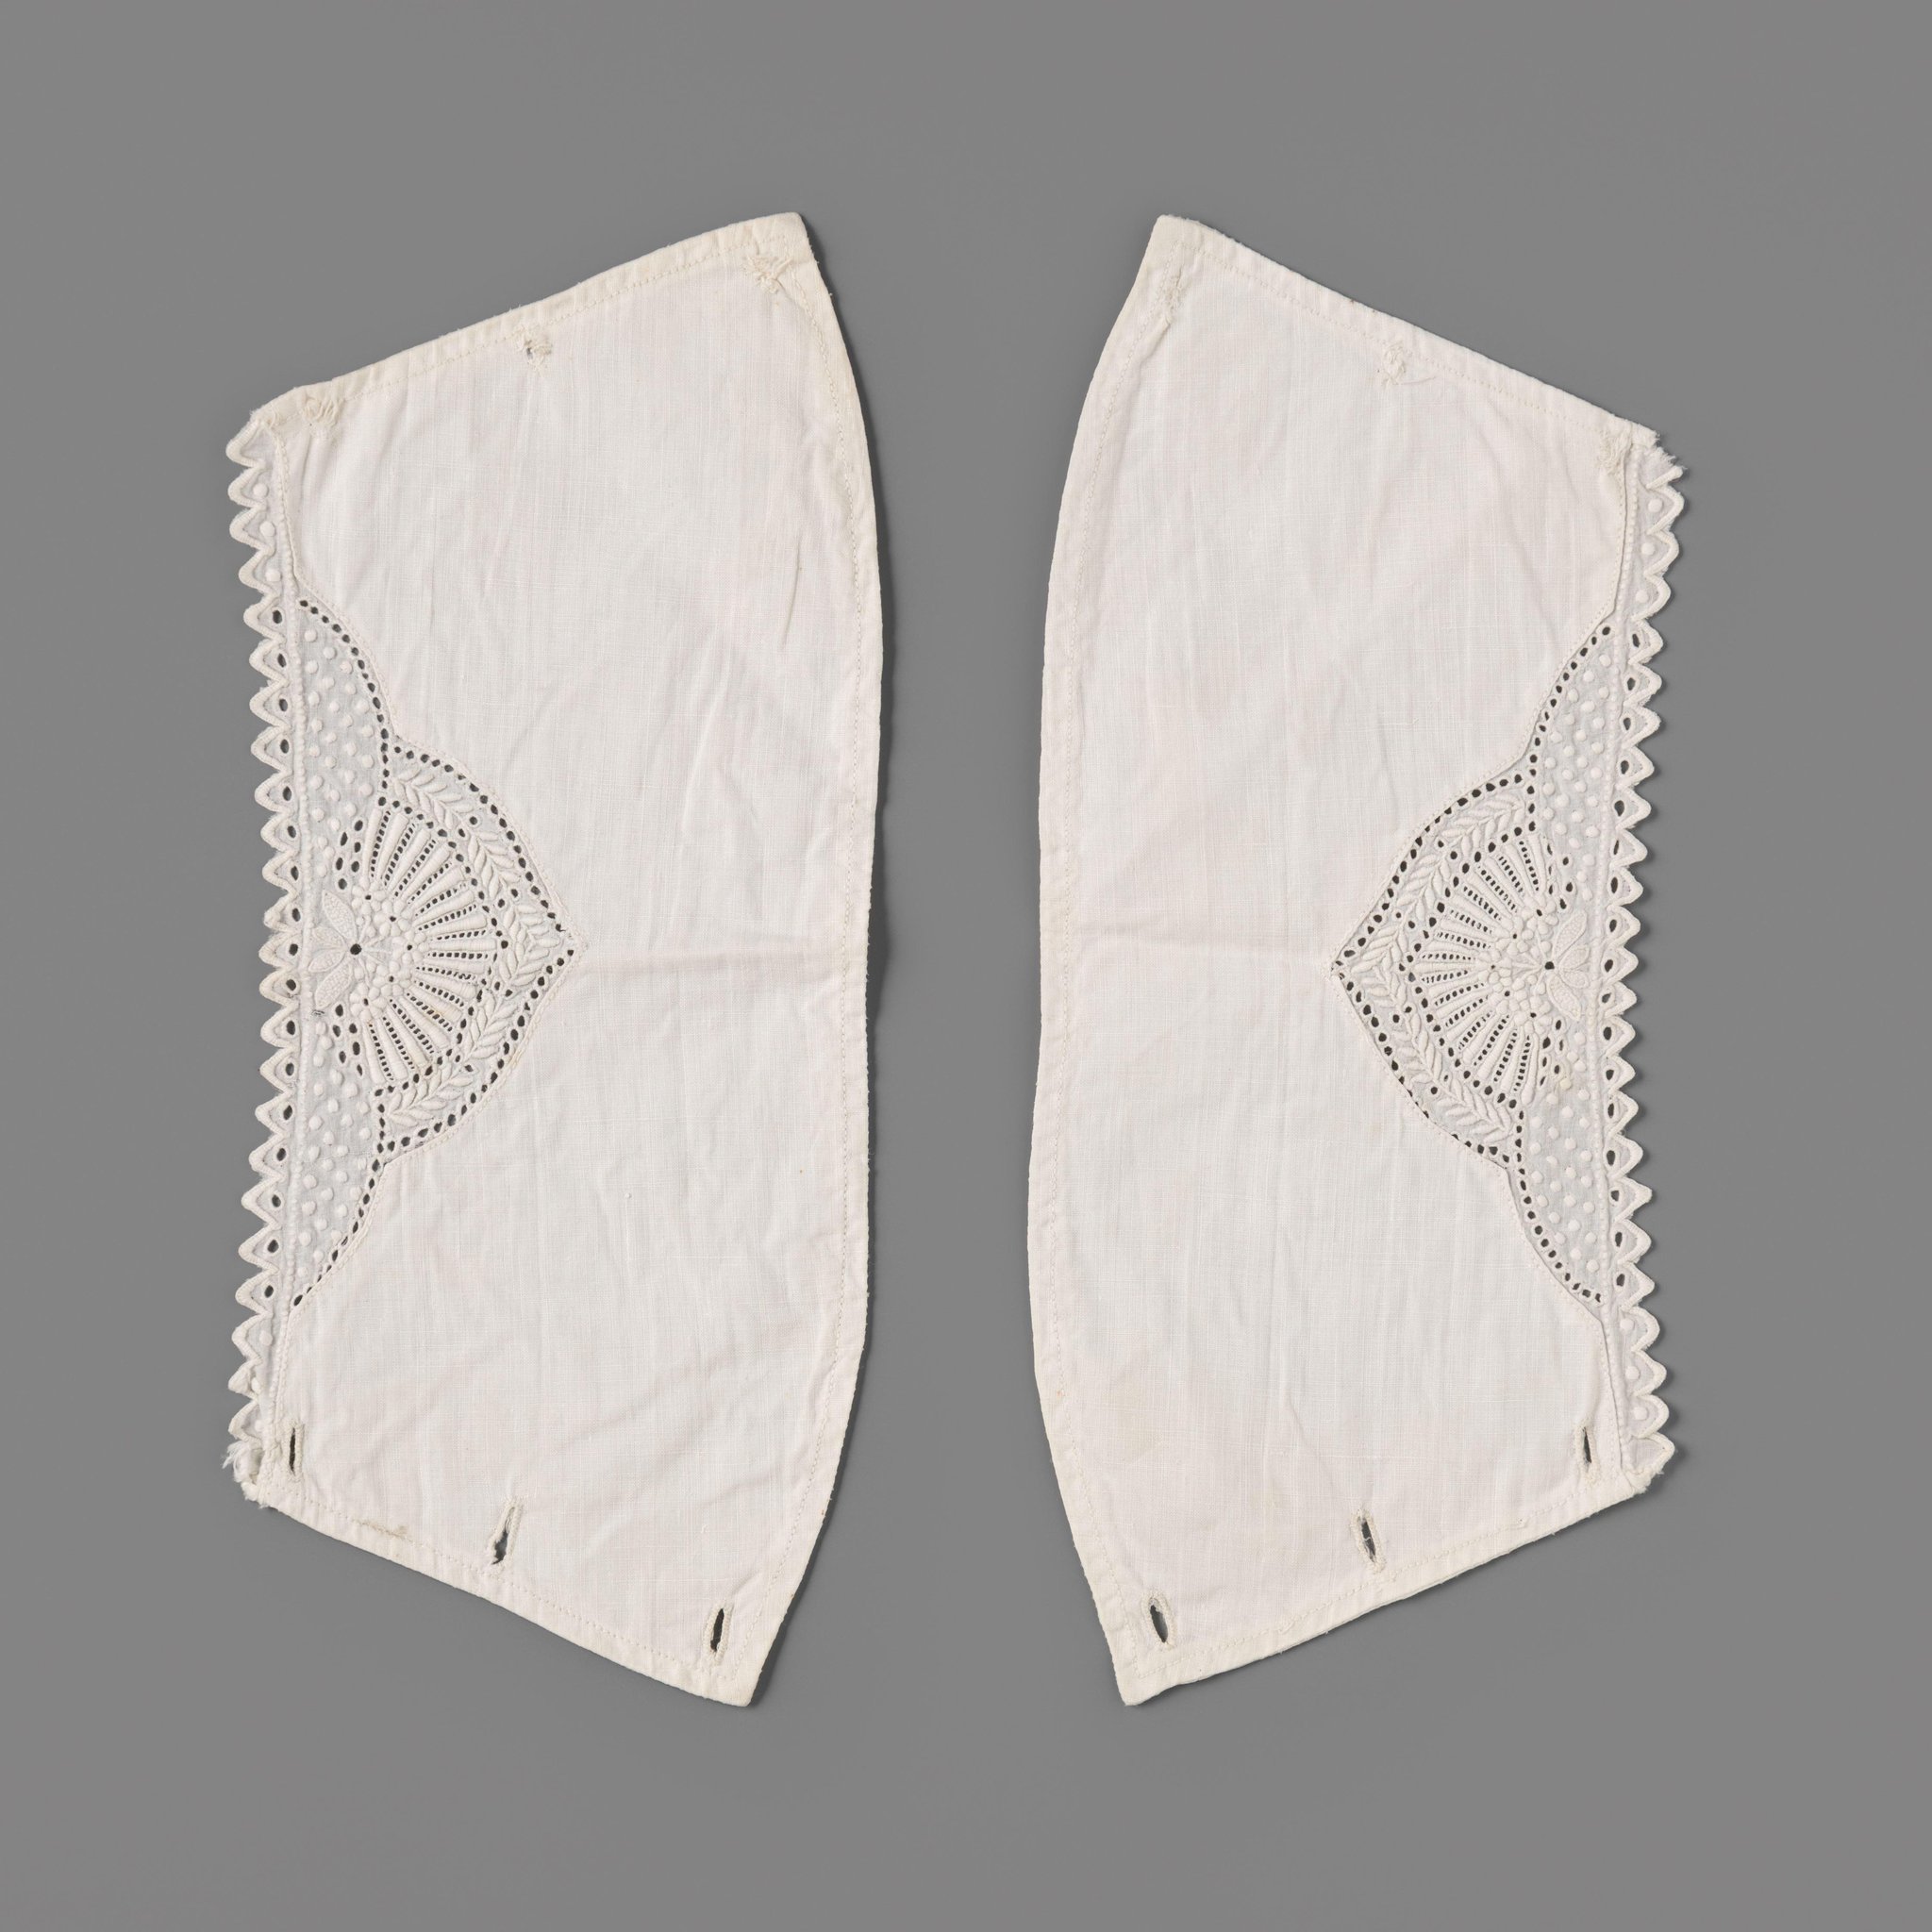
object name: womenswear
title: Manchet van batist versierd met witwerk in de vorm van moesjes, veren en bloemen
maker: Anonymous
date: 1870-1880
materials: textile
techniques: embroidery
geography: netherlands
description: Manchet van batist, versierd met witwerk in de vorm van moesjes, veren en bloemen. De manchet is gevoerd en heeft drie knoopsgaten. Deel van een paar.